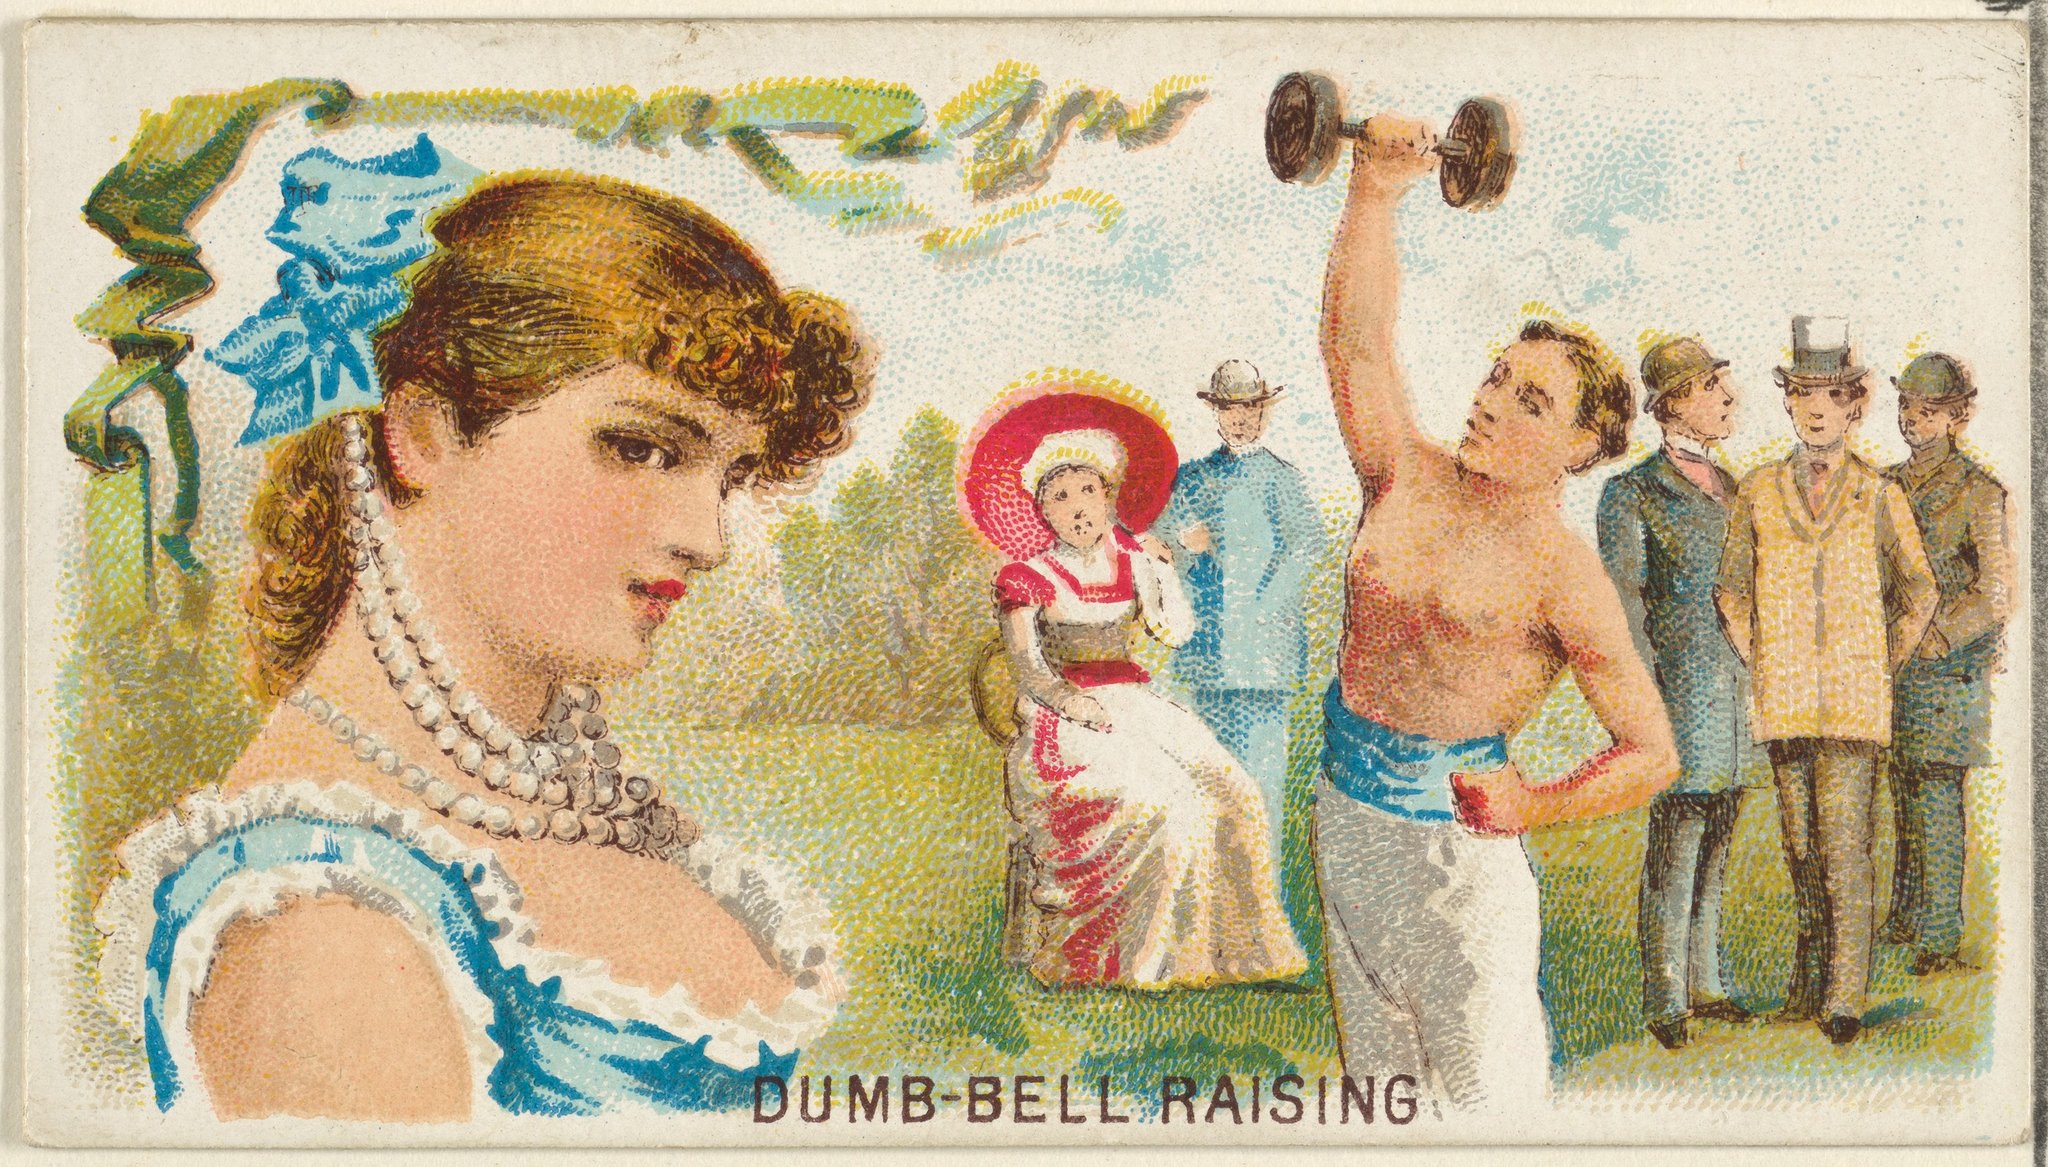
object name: print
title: Dumb-Bell Raising, from the Games and Sports series (N165) for Old Judge Cigarettes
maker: goodwin & company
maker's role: publisher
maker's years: 1850-1950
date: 1889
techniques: color lithograph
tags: men,women,athletes